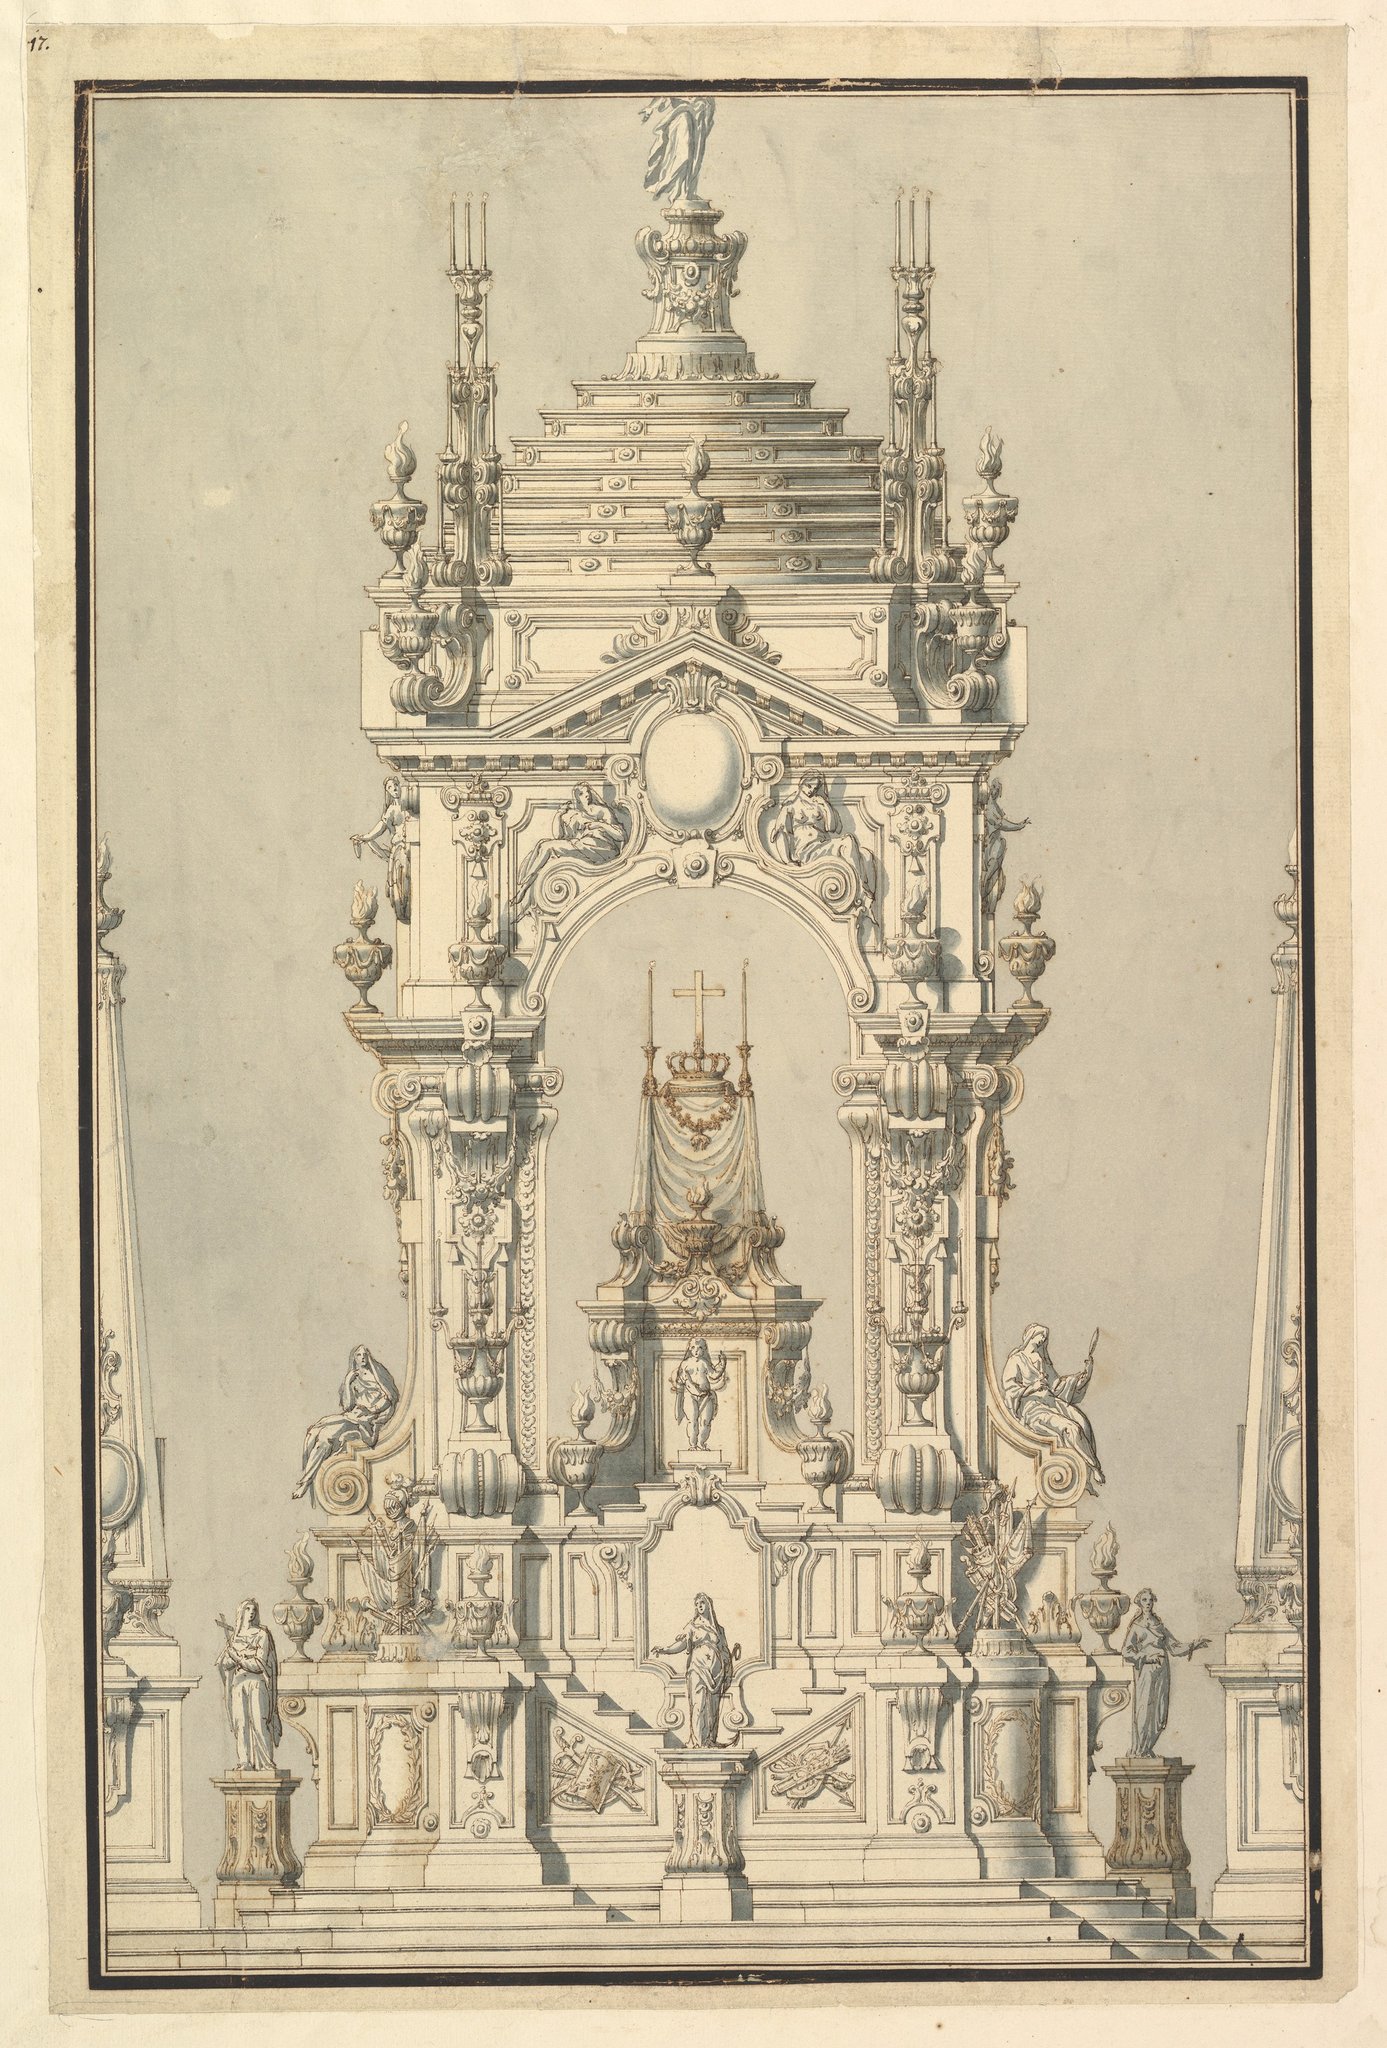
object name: drawing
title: Elevation of a Catafalque with royal Crown and Order of the Golden Fleece, for a Duke of Lorraine, probably Leopold (d. 1729)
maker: giuseppe galli bibiena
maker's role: artist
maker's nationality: italian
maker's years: 1696-1756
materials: ink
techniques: pen, wash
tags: architecture